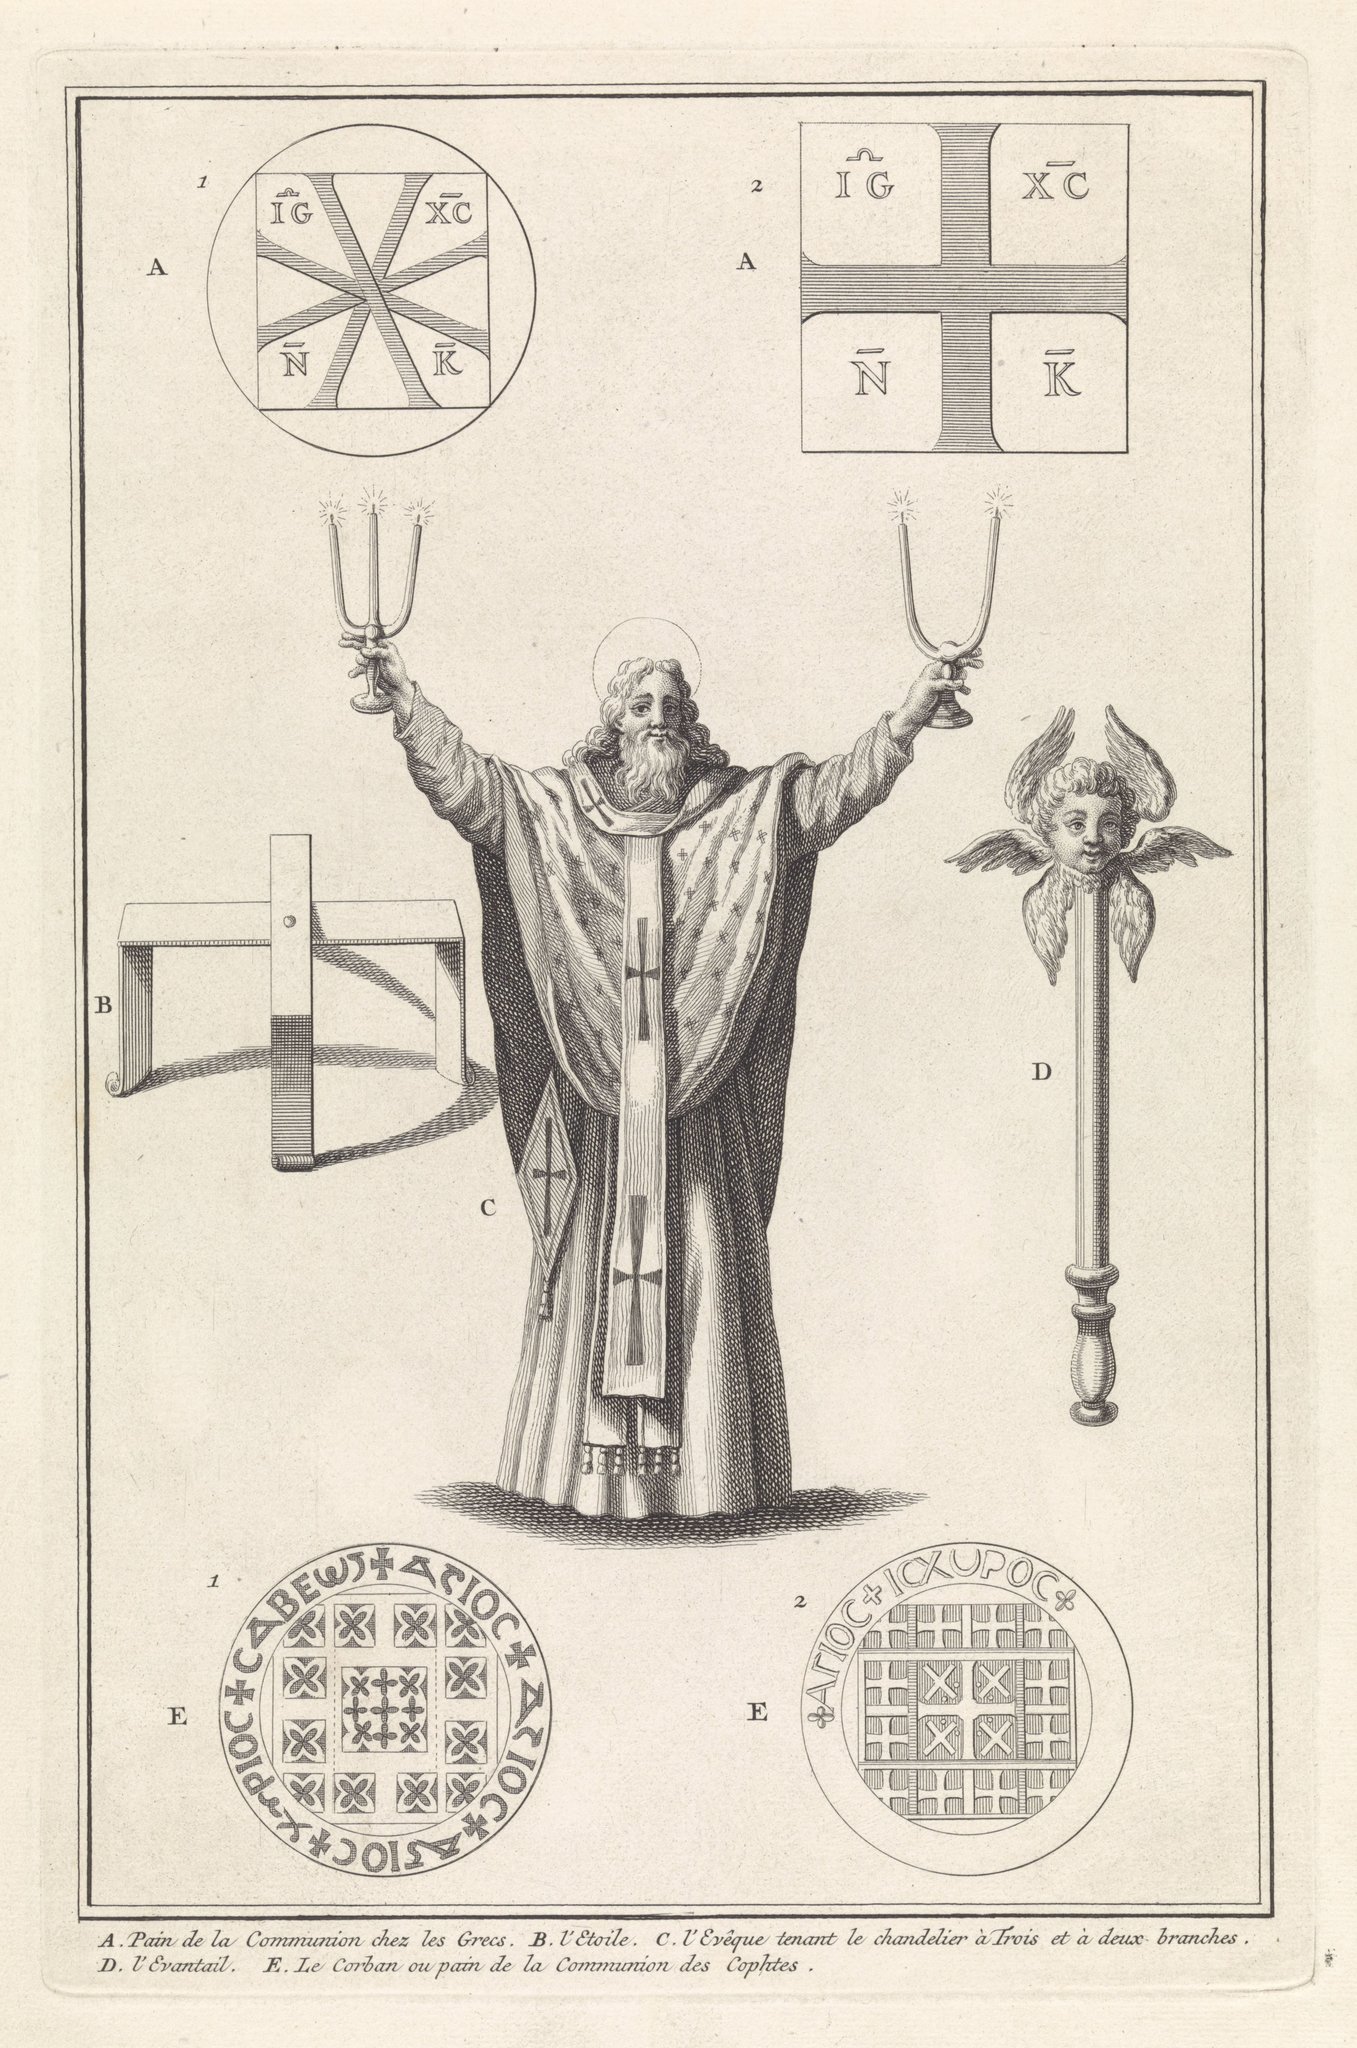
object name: print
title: Grieks-orthodoxe bisschop met attributen uit de orthodoxe traditie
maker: bernard picart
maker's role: draughtsman, print maker, publisher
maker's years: 1673-1733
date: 1733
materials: paper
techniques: engraving, etching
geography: amsterdam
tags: bishop of russian orthodox church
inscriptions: collector's mark: Lugt 2228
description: Blad met zeven geletterde voorstellingen en onderaan in de marge een legenda. In het midden toont een Grieks-orthodoxe bisschop een drie- en twee-armige kandelaar. De bovenste figuren (A) tonen de hostie, zoals deze wordt gebruikt bij de viering van de eucharistie door de Grieks-Orthodoxen. Naast de bisschop een kruisvormig voorwerp en een staf. De onderste twee figuren (E) onen de hostie, zoals deze wordt gebruikt bij de viering van de eucharistie door de Koptisch-orthodoxe christenen.